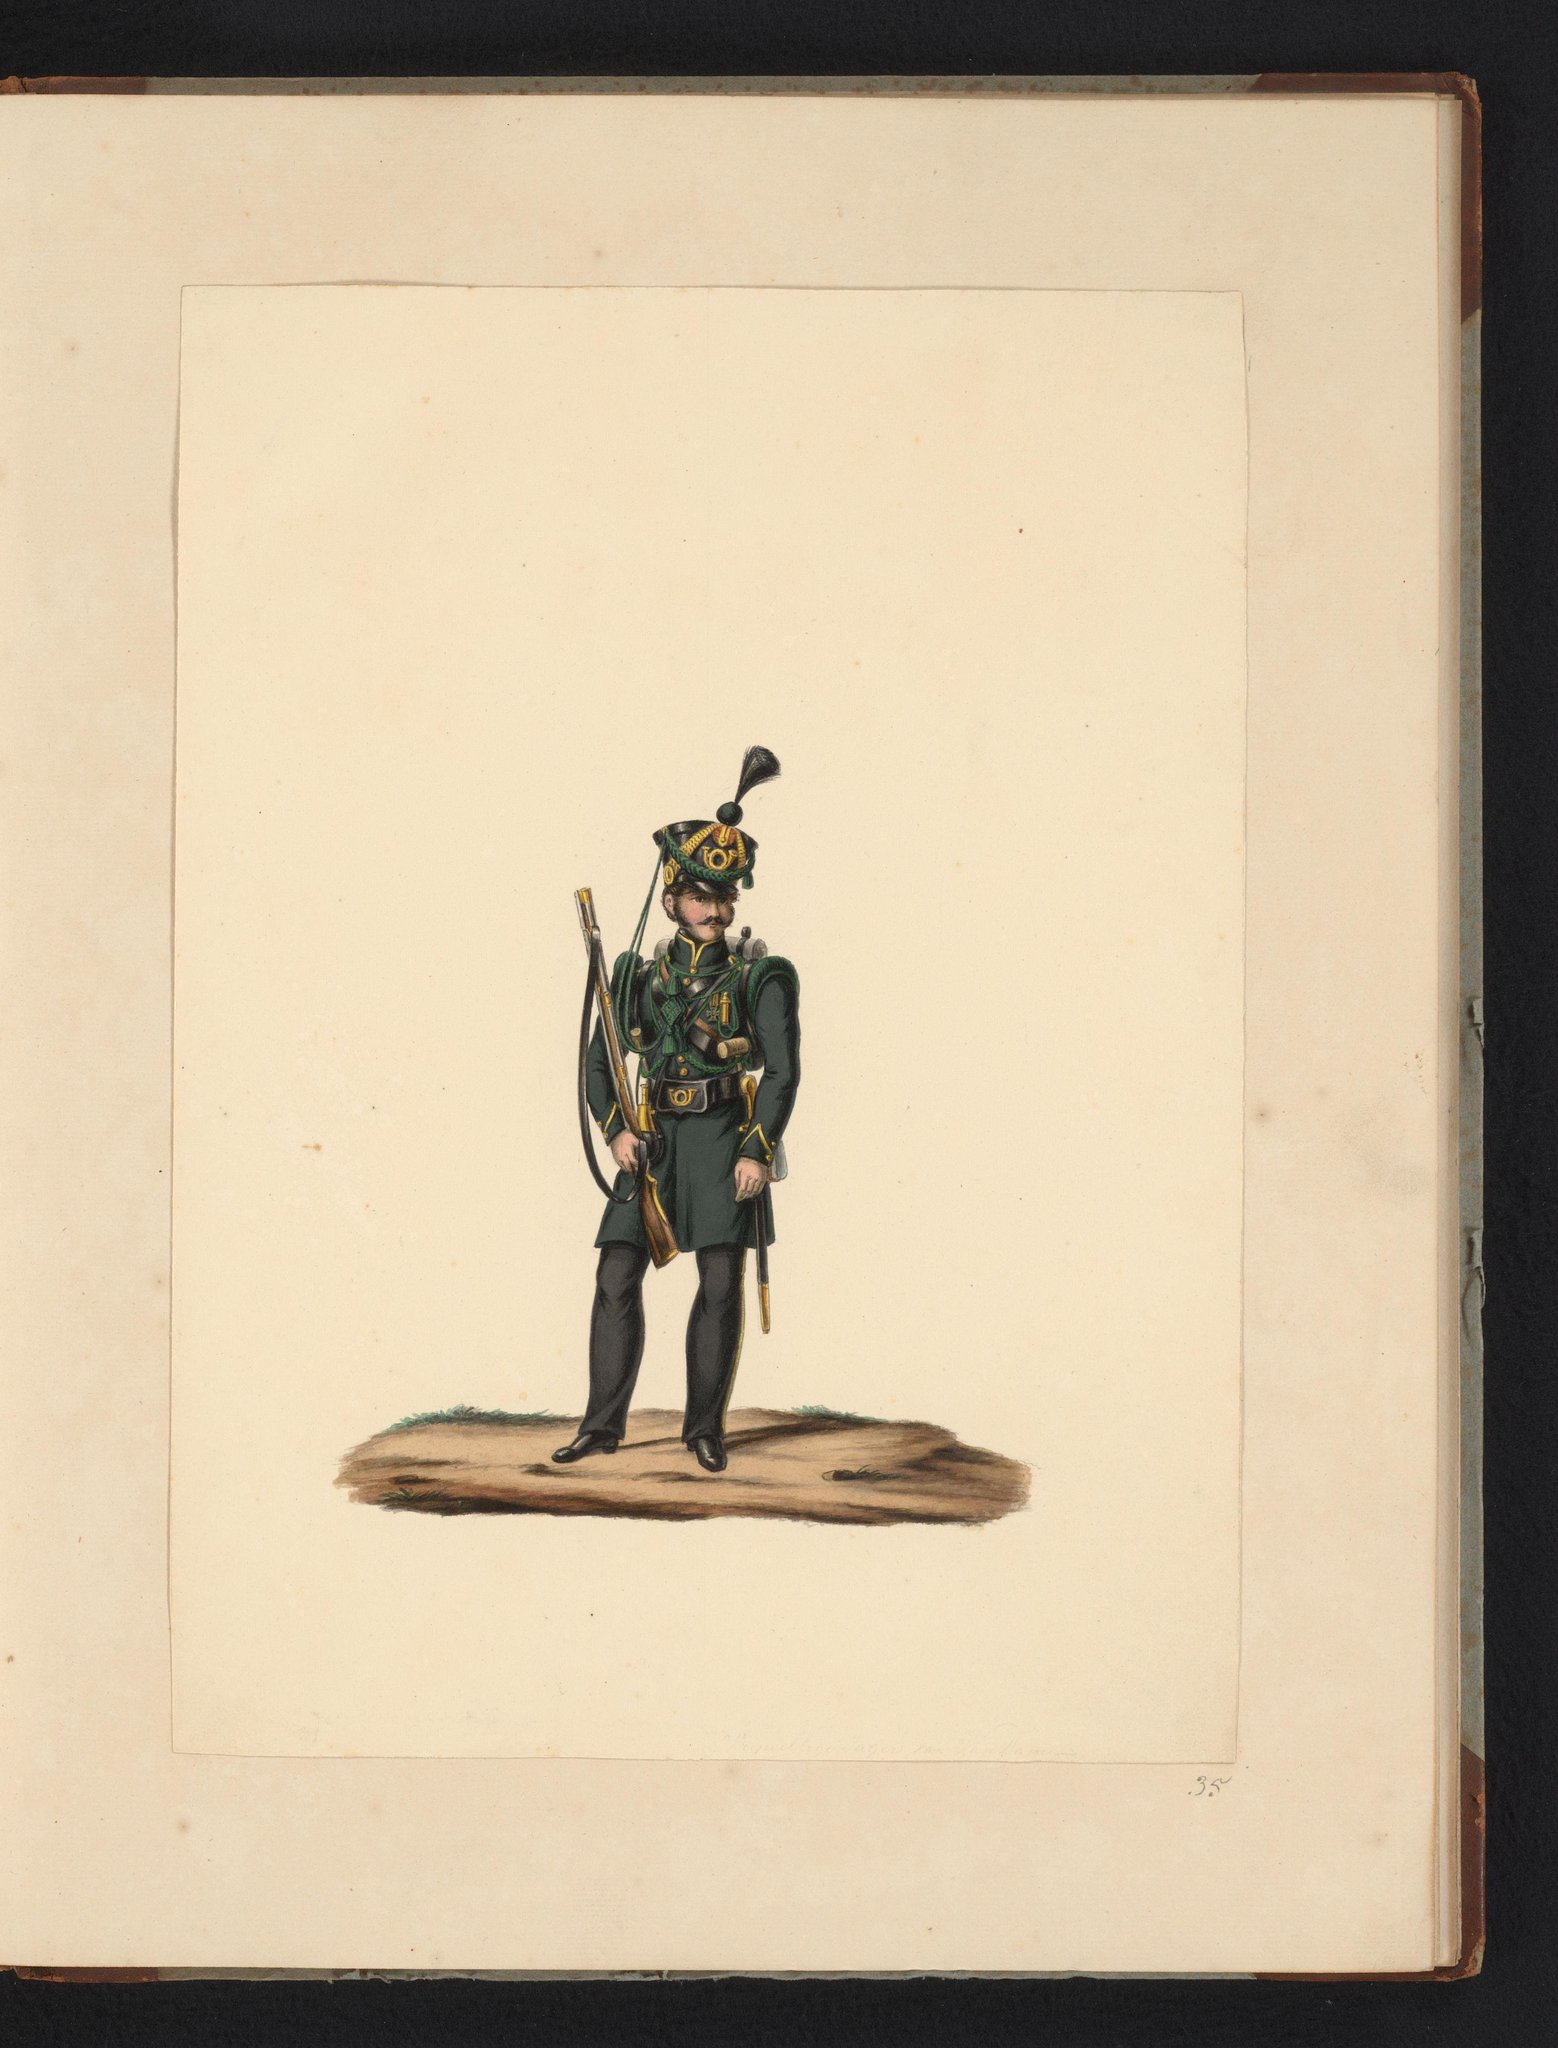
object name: costume print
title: Vrijwillige jager van Van Dam, 1830-1831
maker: Anonymous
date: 1831-1832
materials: paper, pencil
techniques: brush, lacquer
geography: netherlands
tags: professional clothes, (military) uniforms, netherlands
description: Een jager van de Compagnie Vrijwillige Jagers van Van Dam, te voet. Onderdeel van het album met 39 ingeplakte tekeningen van militairen van de Koninklijke Nederlandsche Armee uit 1830-1831.